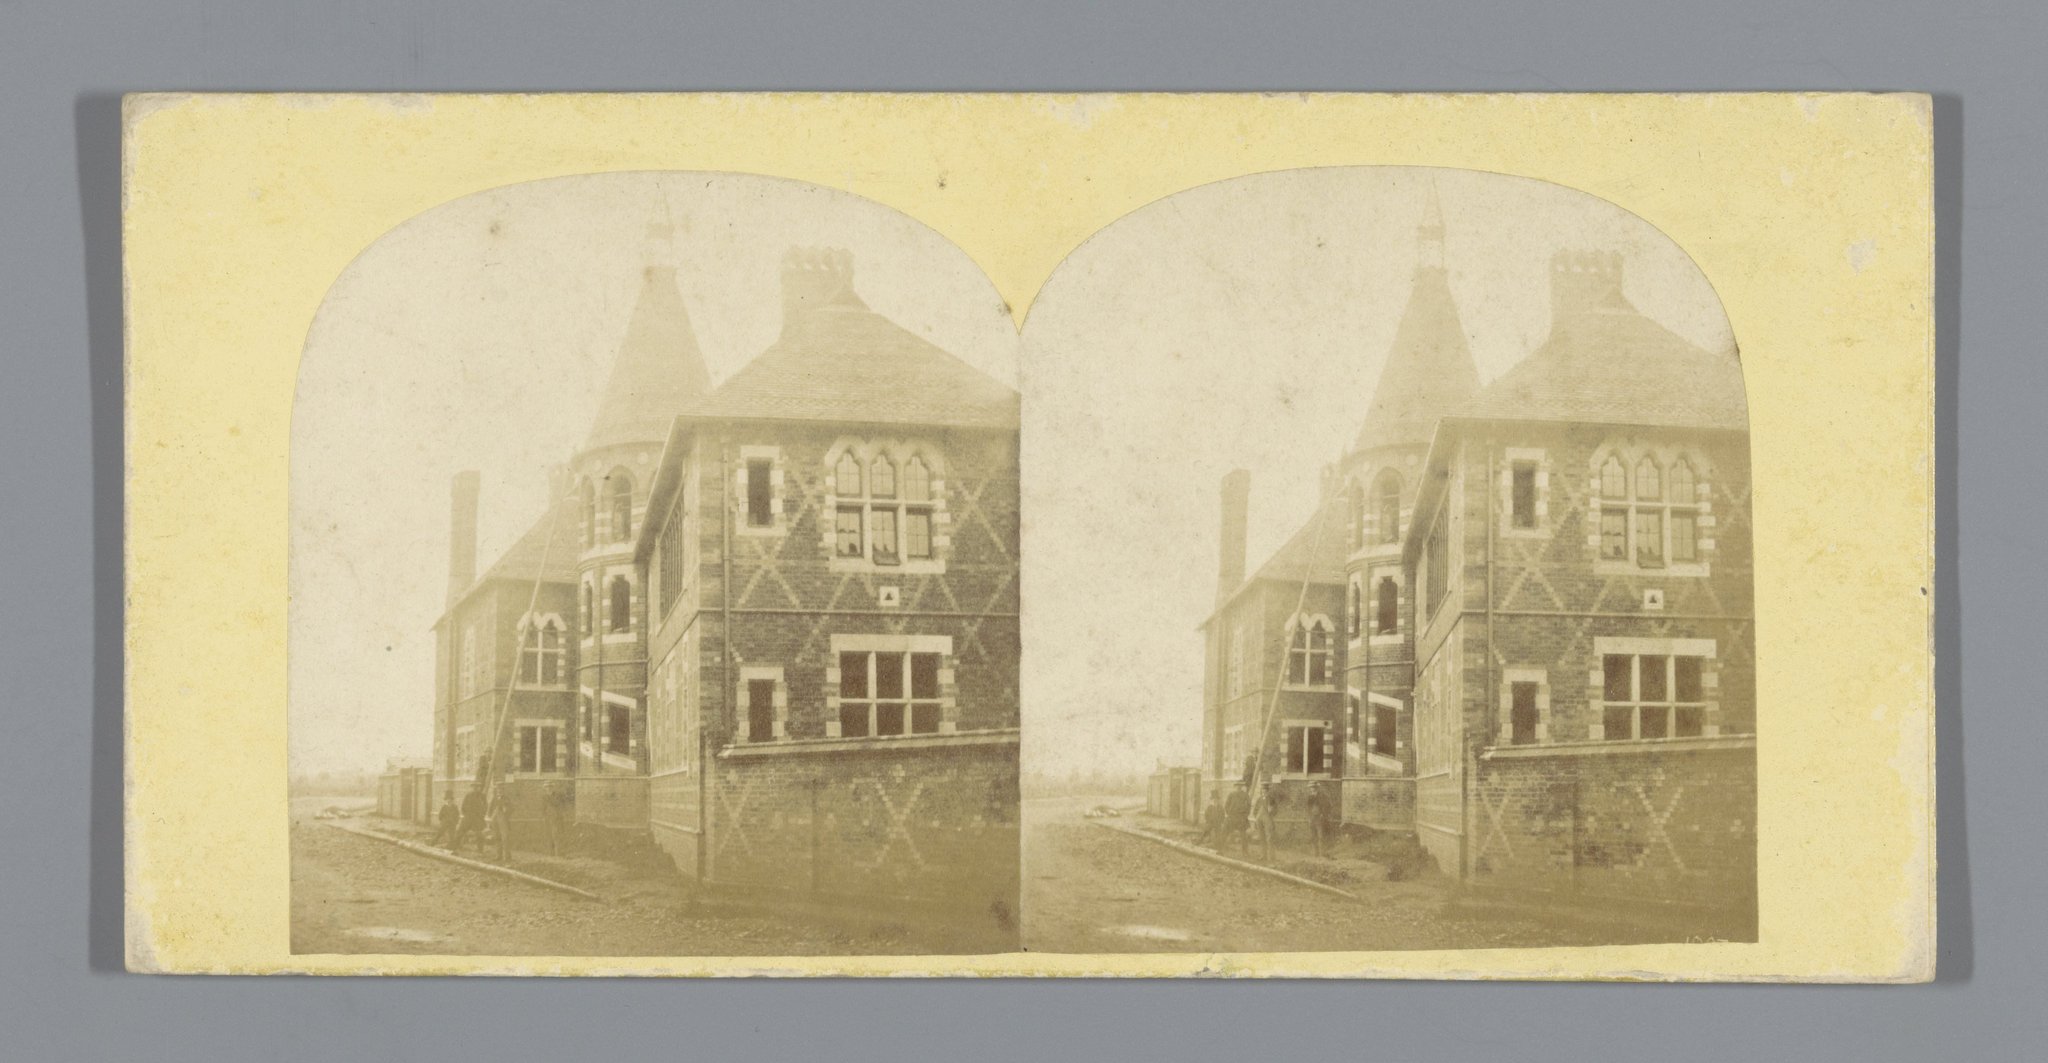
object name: stereograph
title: Gezicht op een gebouw van de Rugby School te Warwickshire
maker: Anonymous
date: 1850-1875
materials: cardboard, photographic support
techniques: albumen print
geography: warwickshire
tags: secondary education, housing, façade (of house or building)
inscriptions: inscription: ‘Sich House Rugby School’